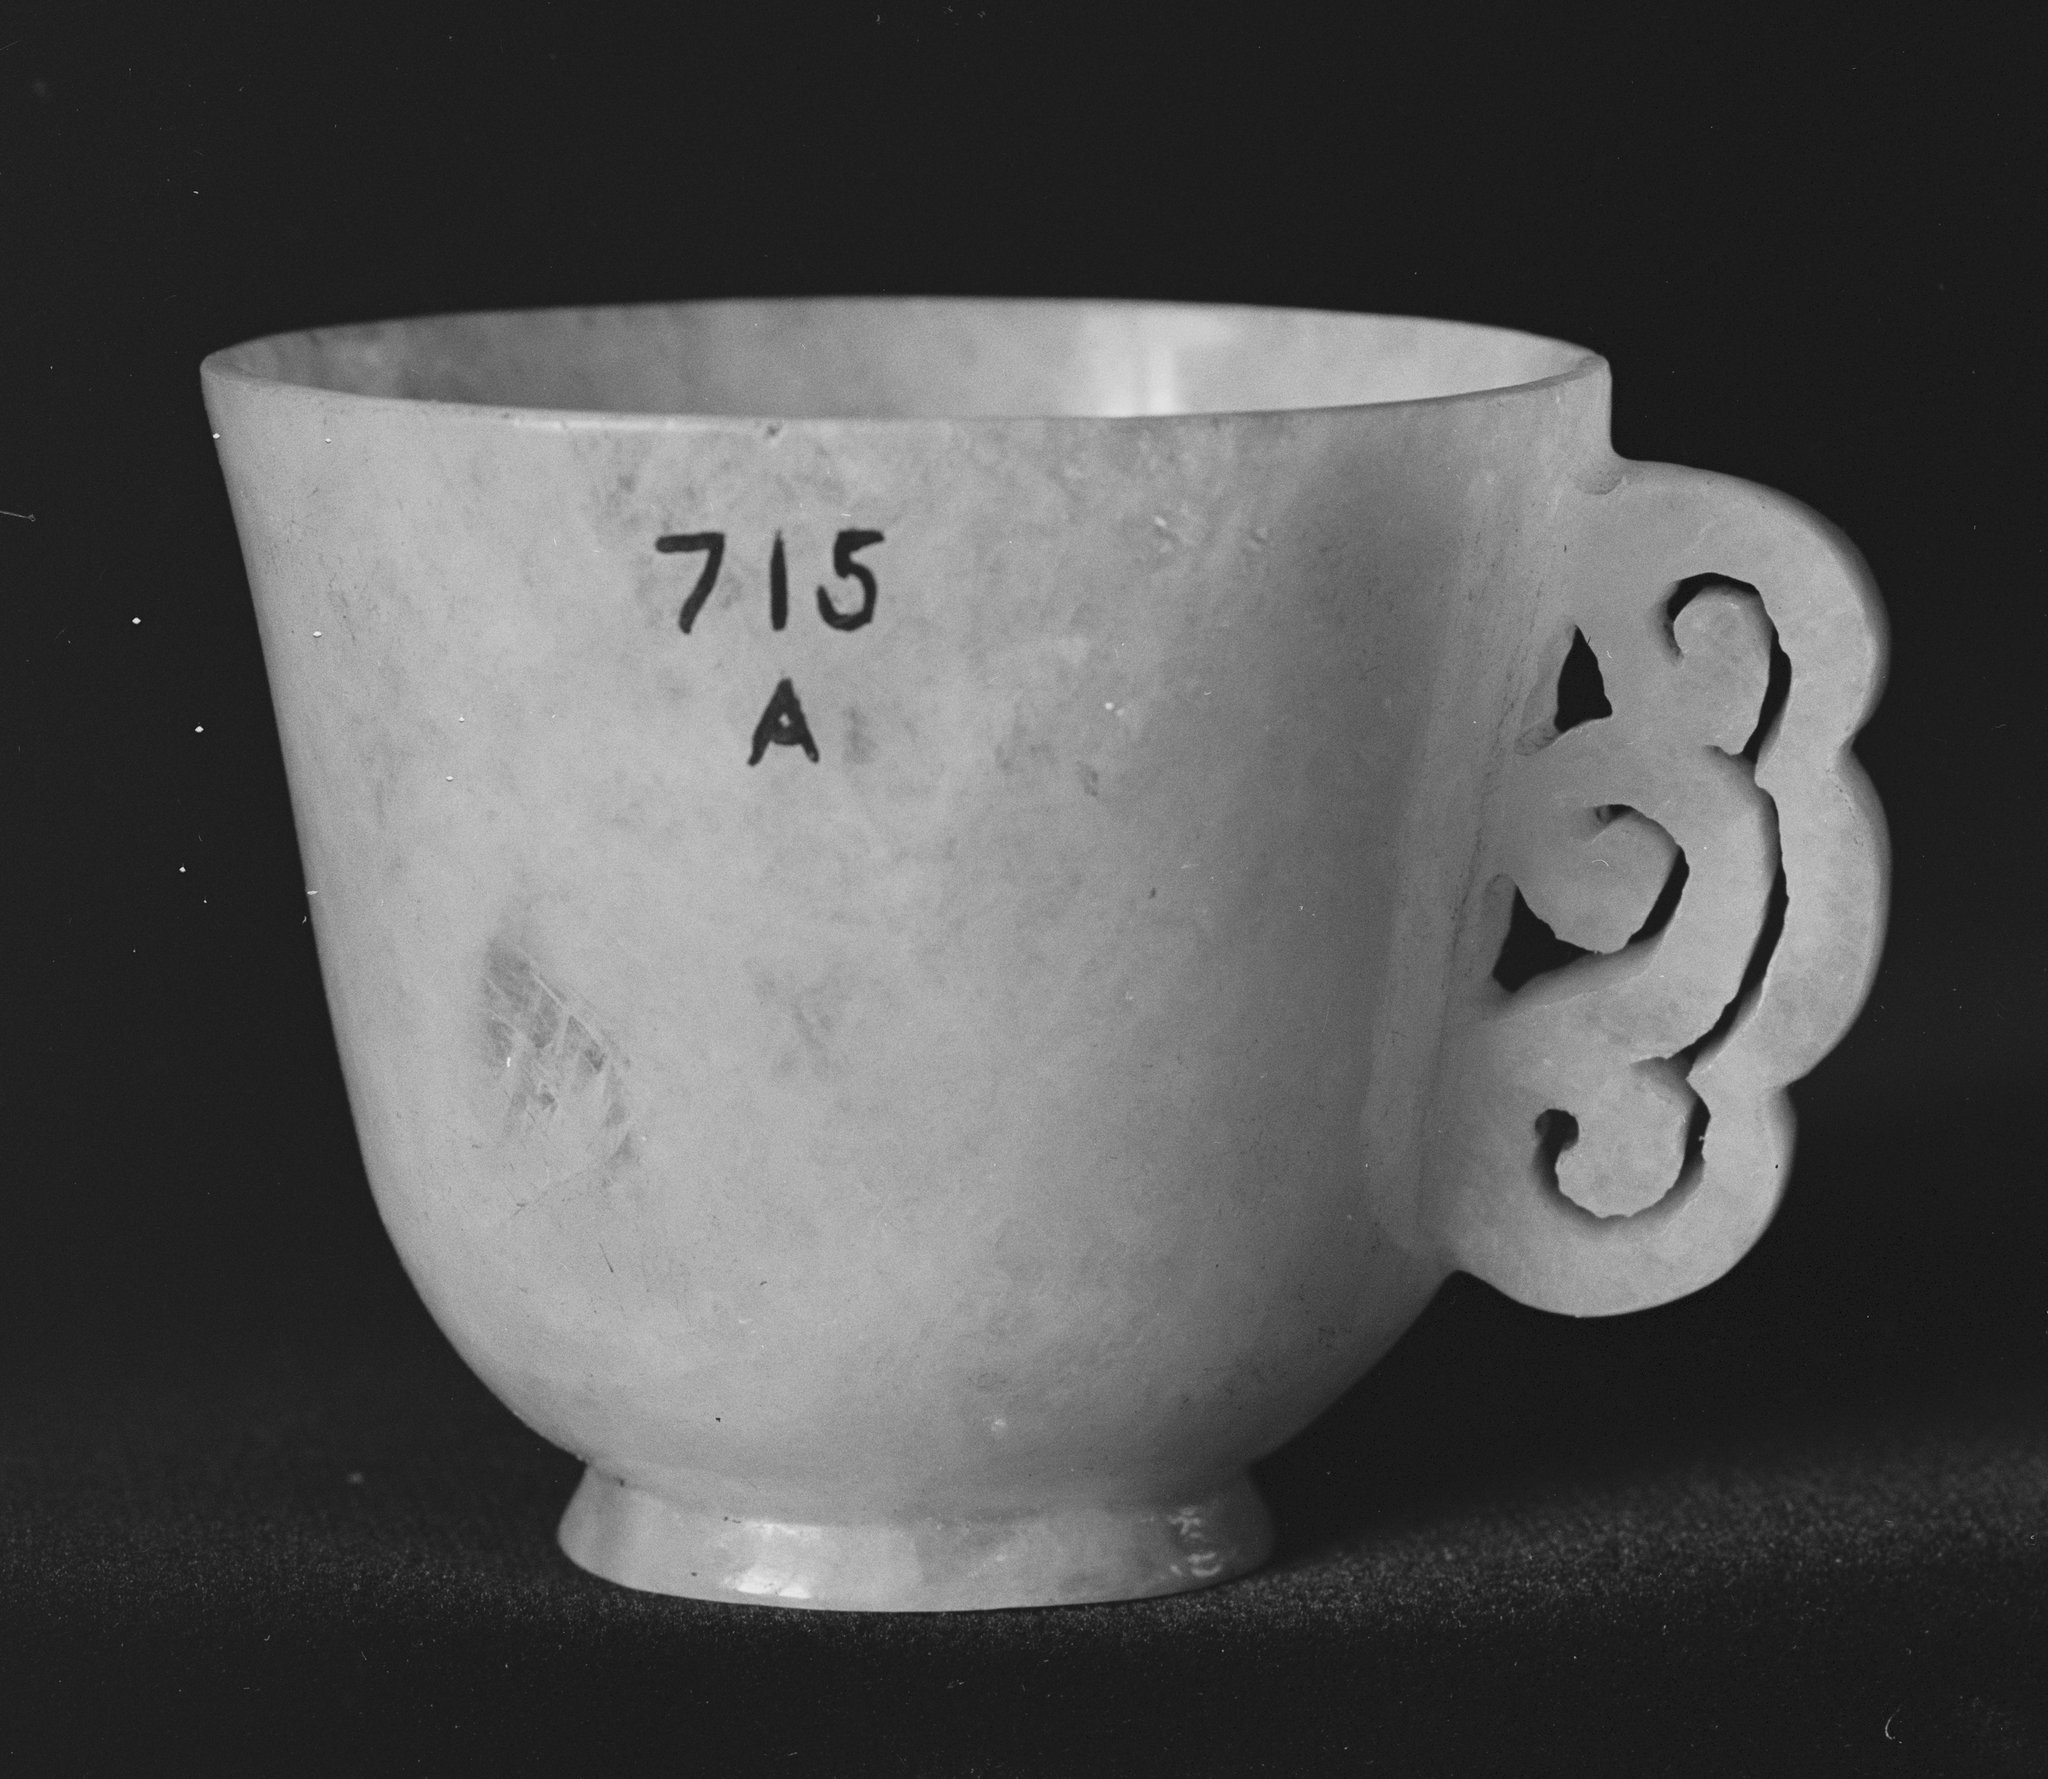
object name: wine cup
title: Set of Eight Wine Cups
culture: chinese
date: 1796-1875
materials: jade